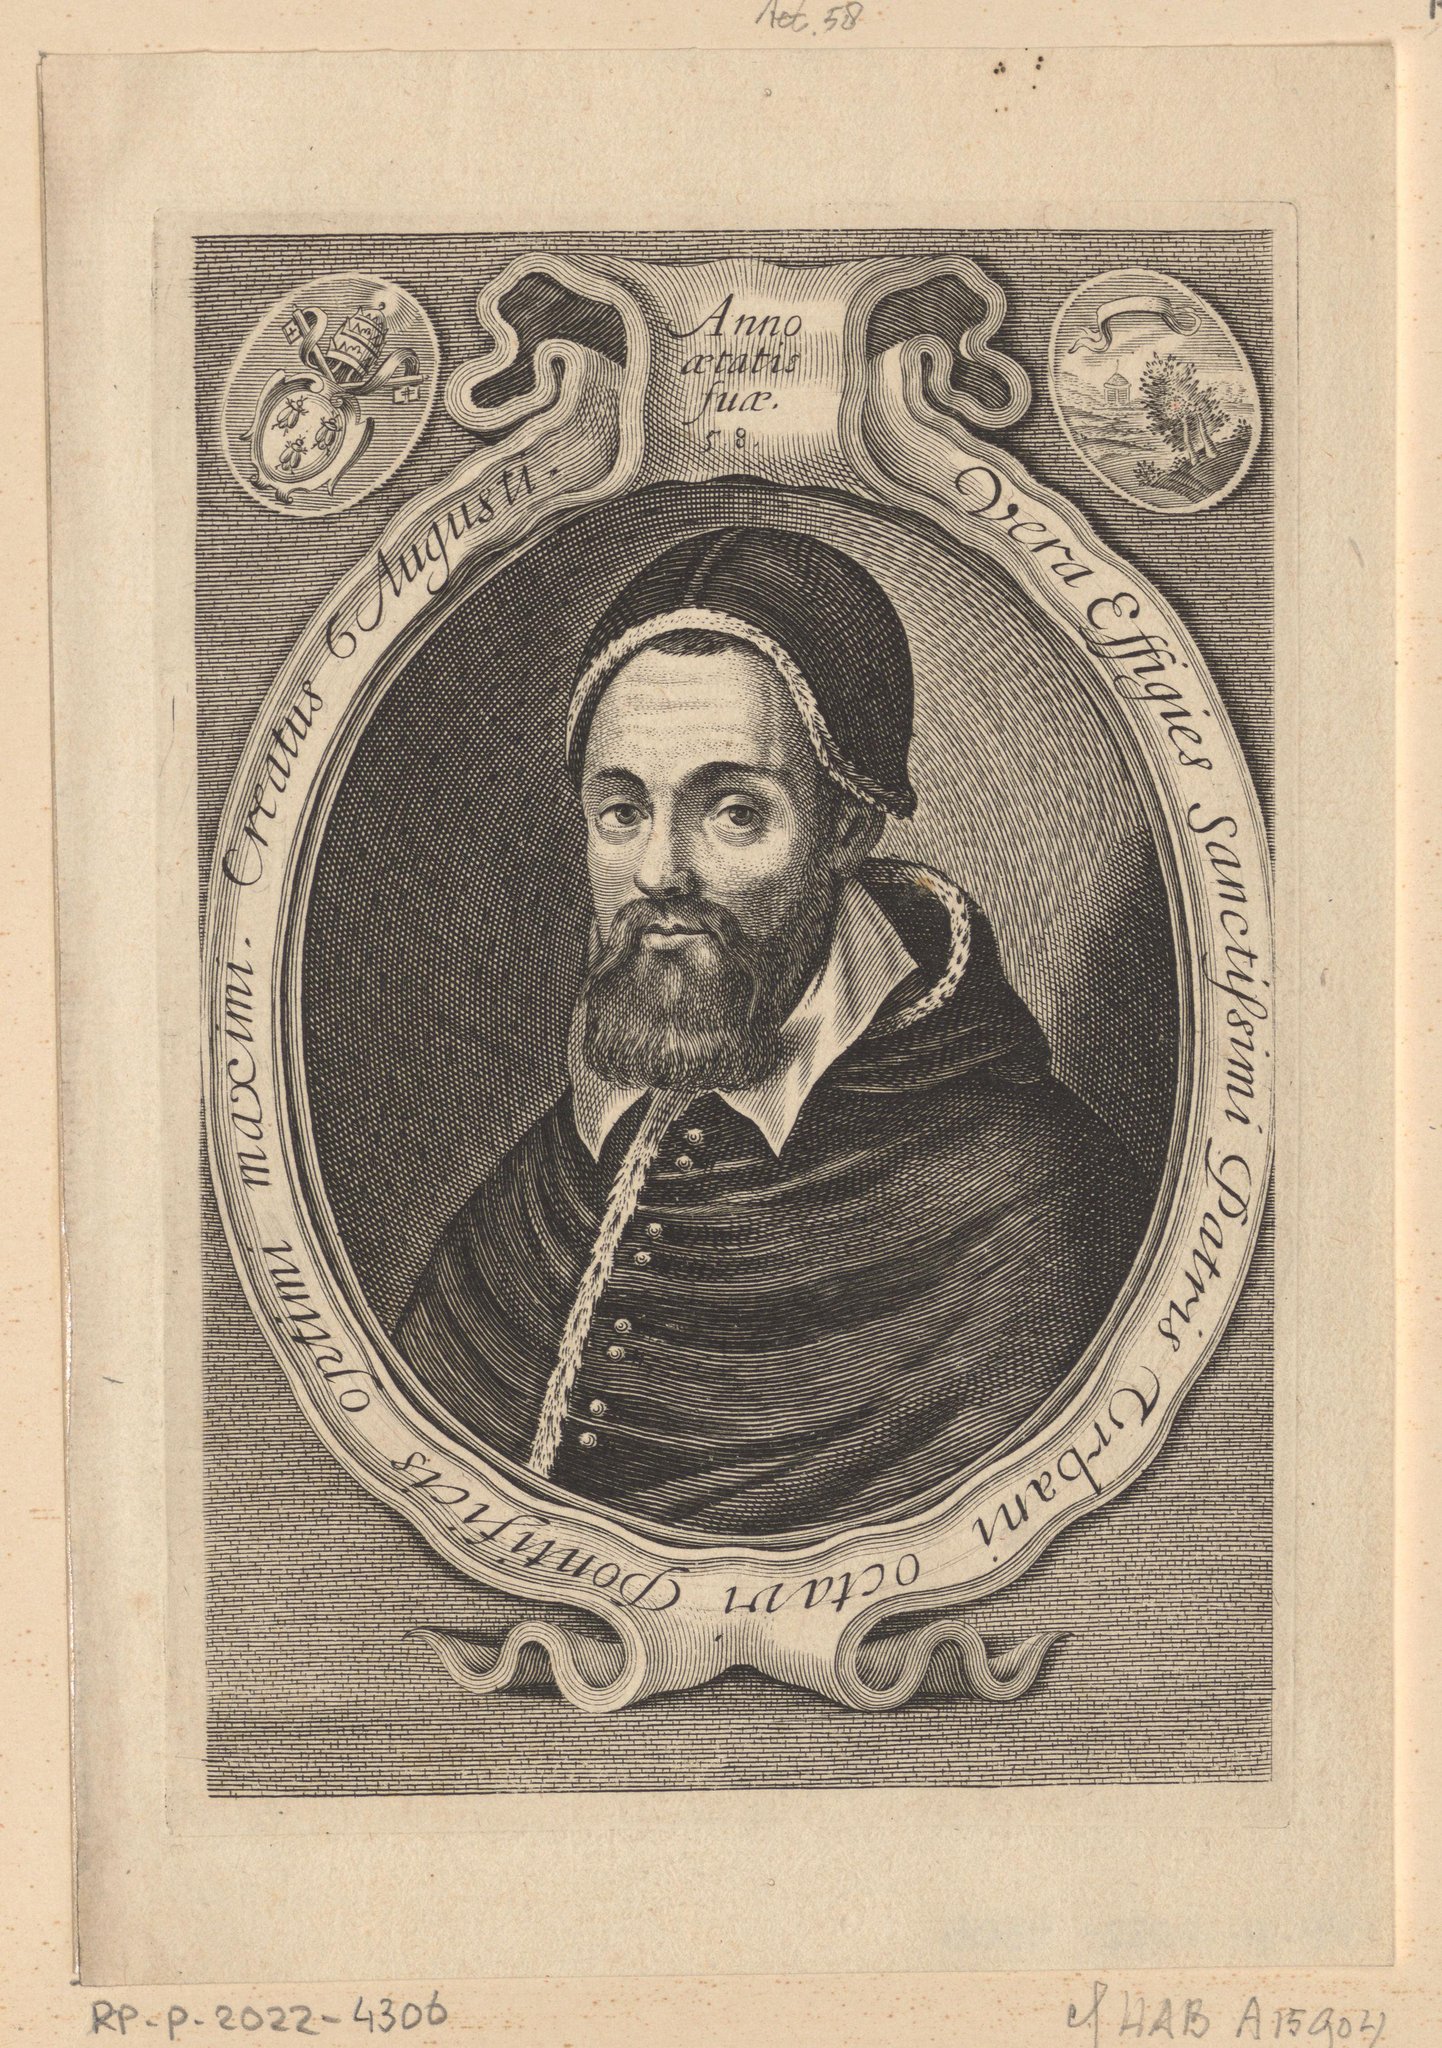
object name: print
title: Portret van paus Urbanus VIII op 58-jarige leeftijd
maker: Anonymous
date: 1626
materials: paper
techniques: engraving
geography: northern netherlands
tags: rome, clergyman, urbanus viii, historical persons, pope